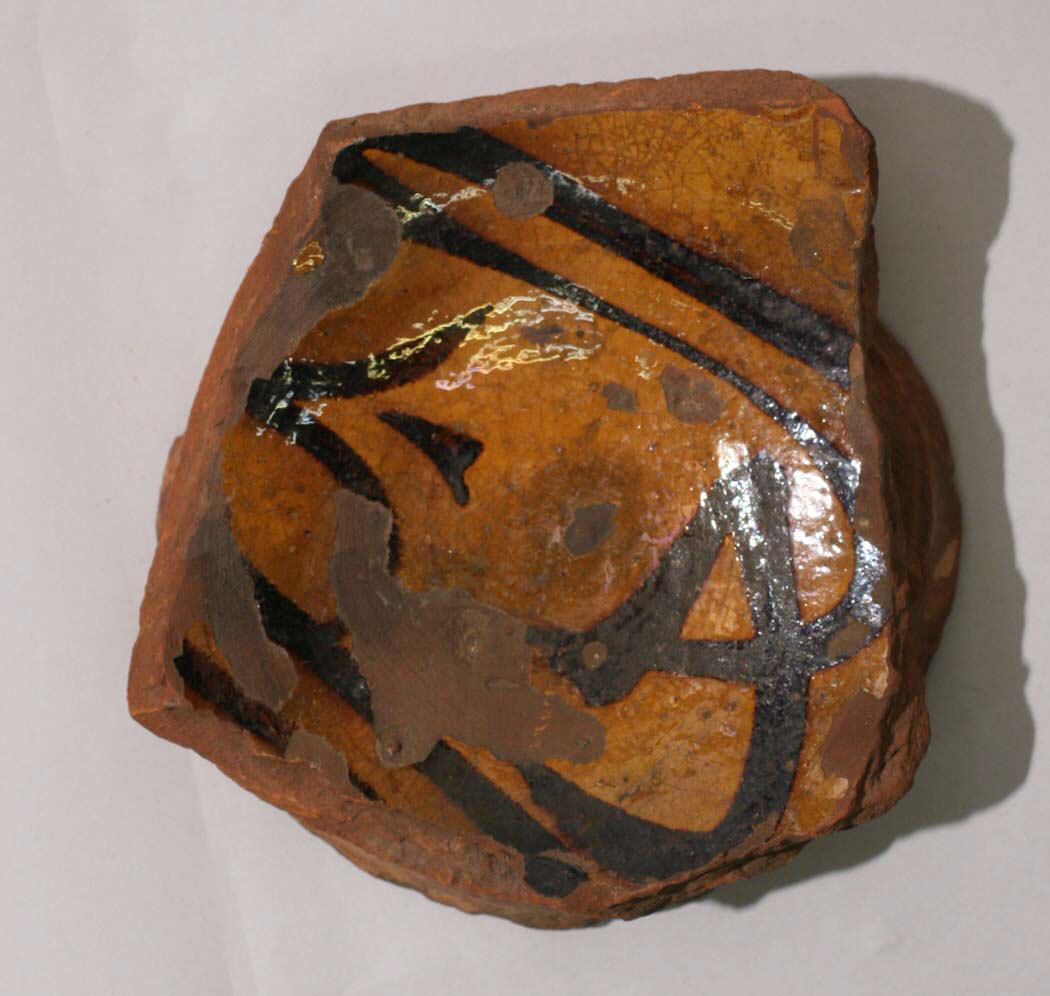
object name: ceramic fragment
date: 1301-1500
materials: earthenware, glaze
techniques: painting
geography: egypt